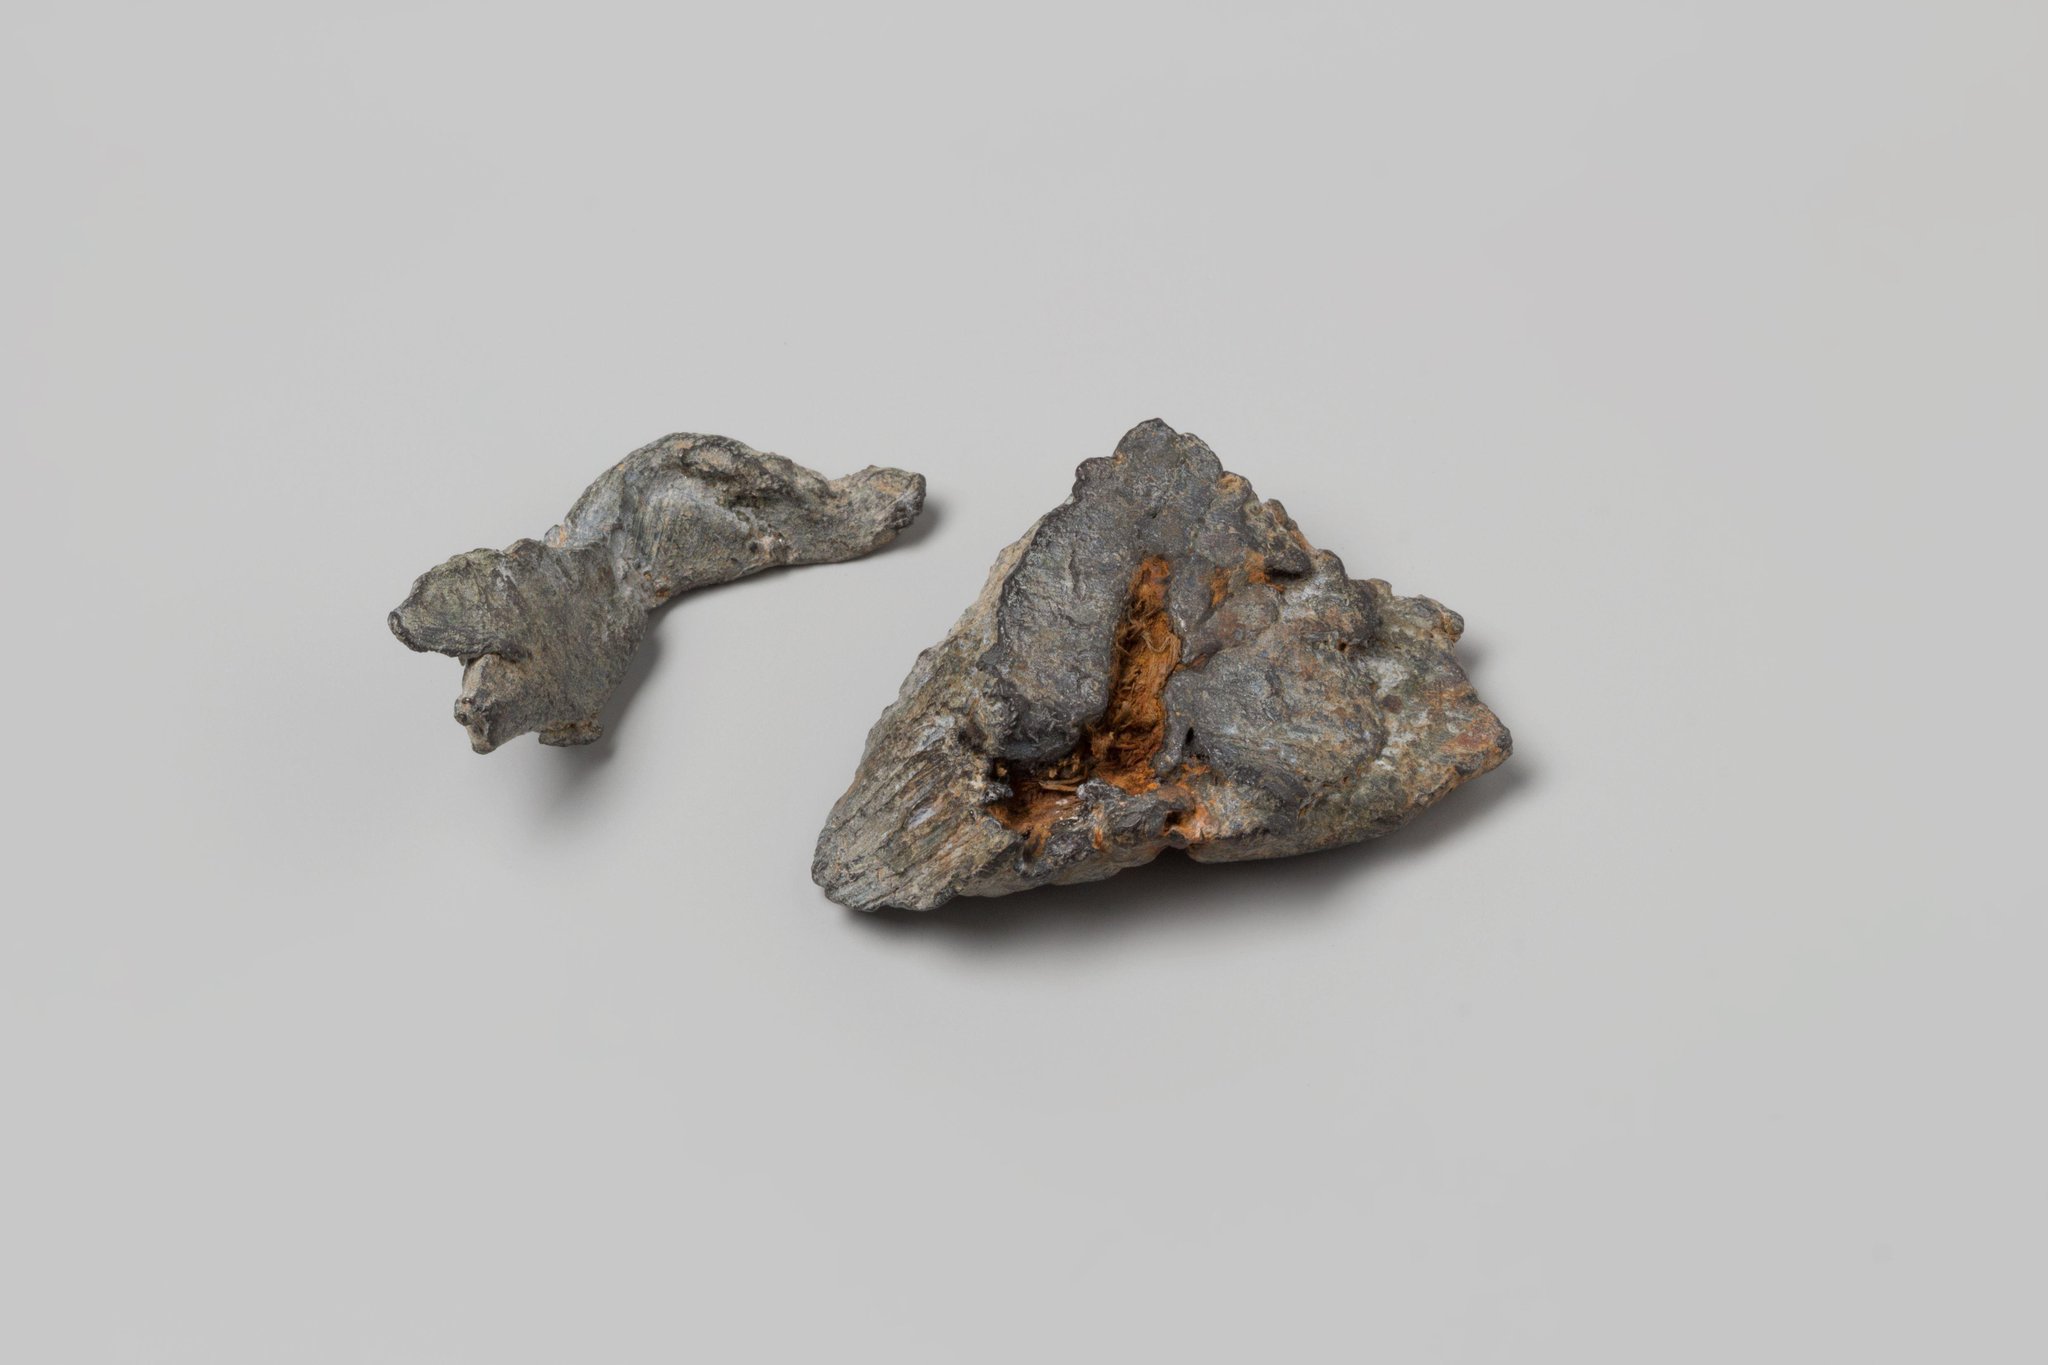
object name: fragment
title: Fragmenten lood uit het wrak van de Oost-Indiëvaarder Hollandia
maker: Anonymous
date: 1700-1743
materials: lead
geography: netherlands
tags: verenigde oostindische compagnie, hollandia (schip), annet